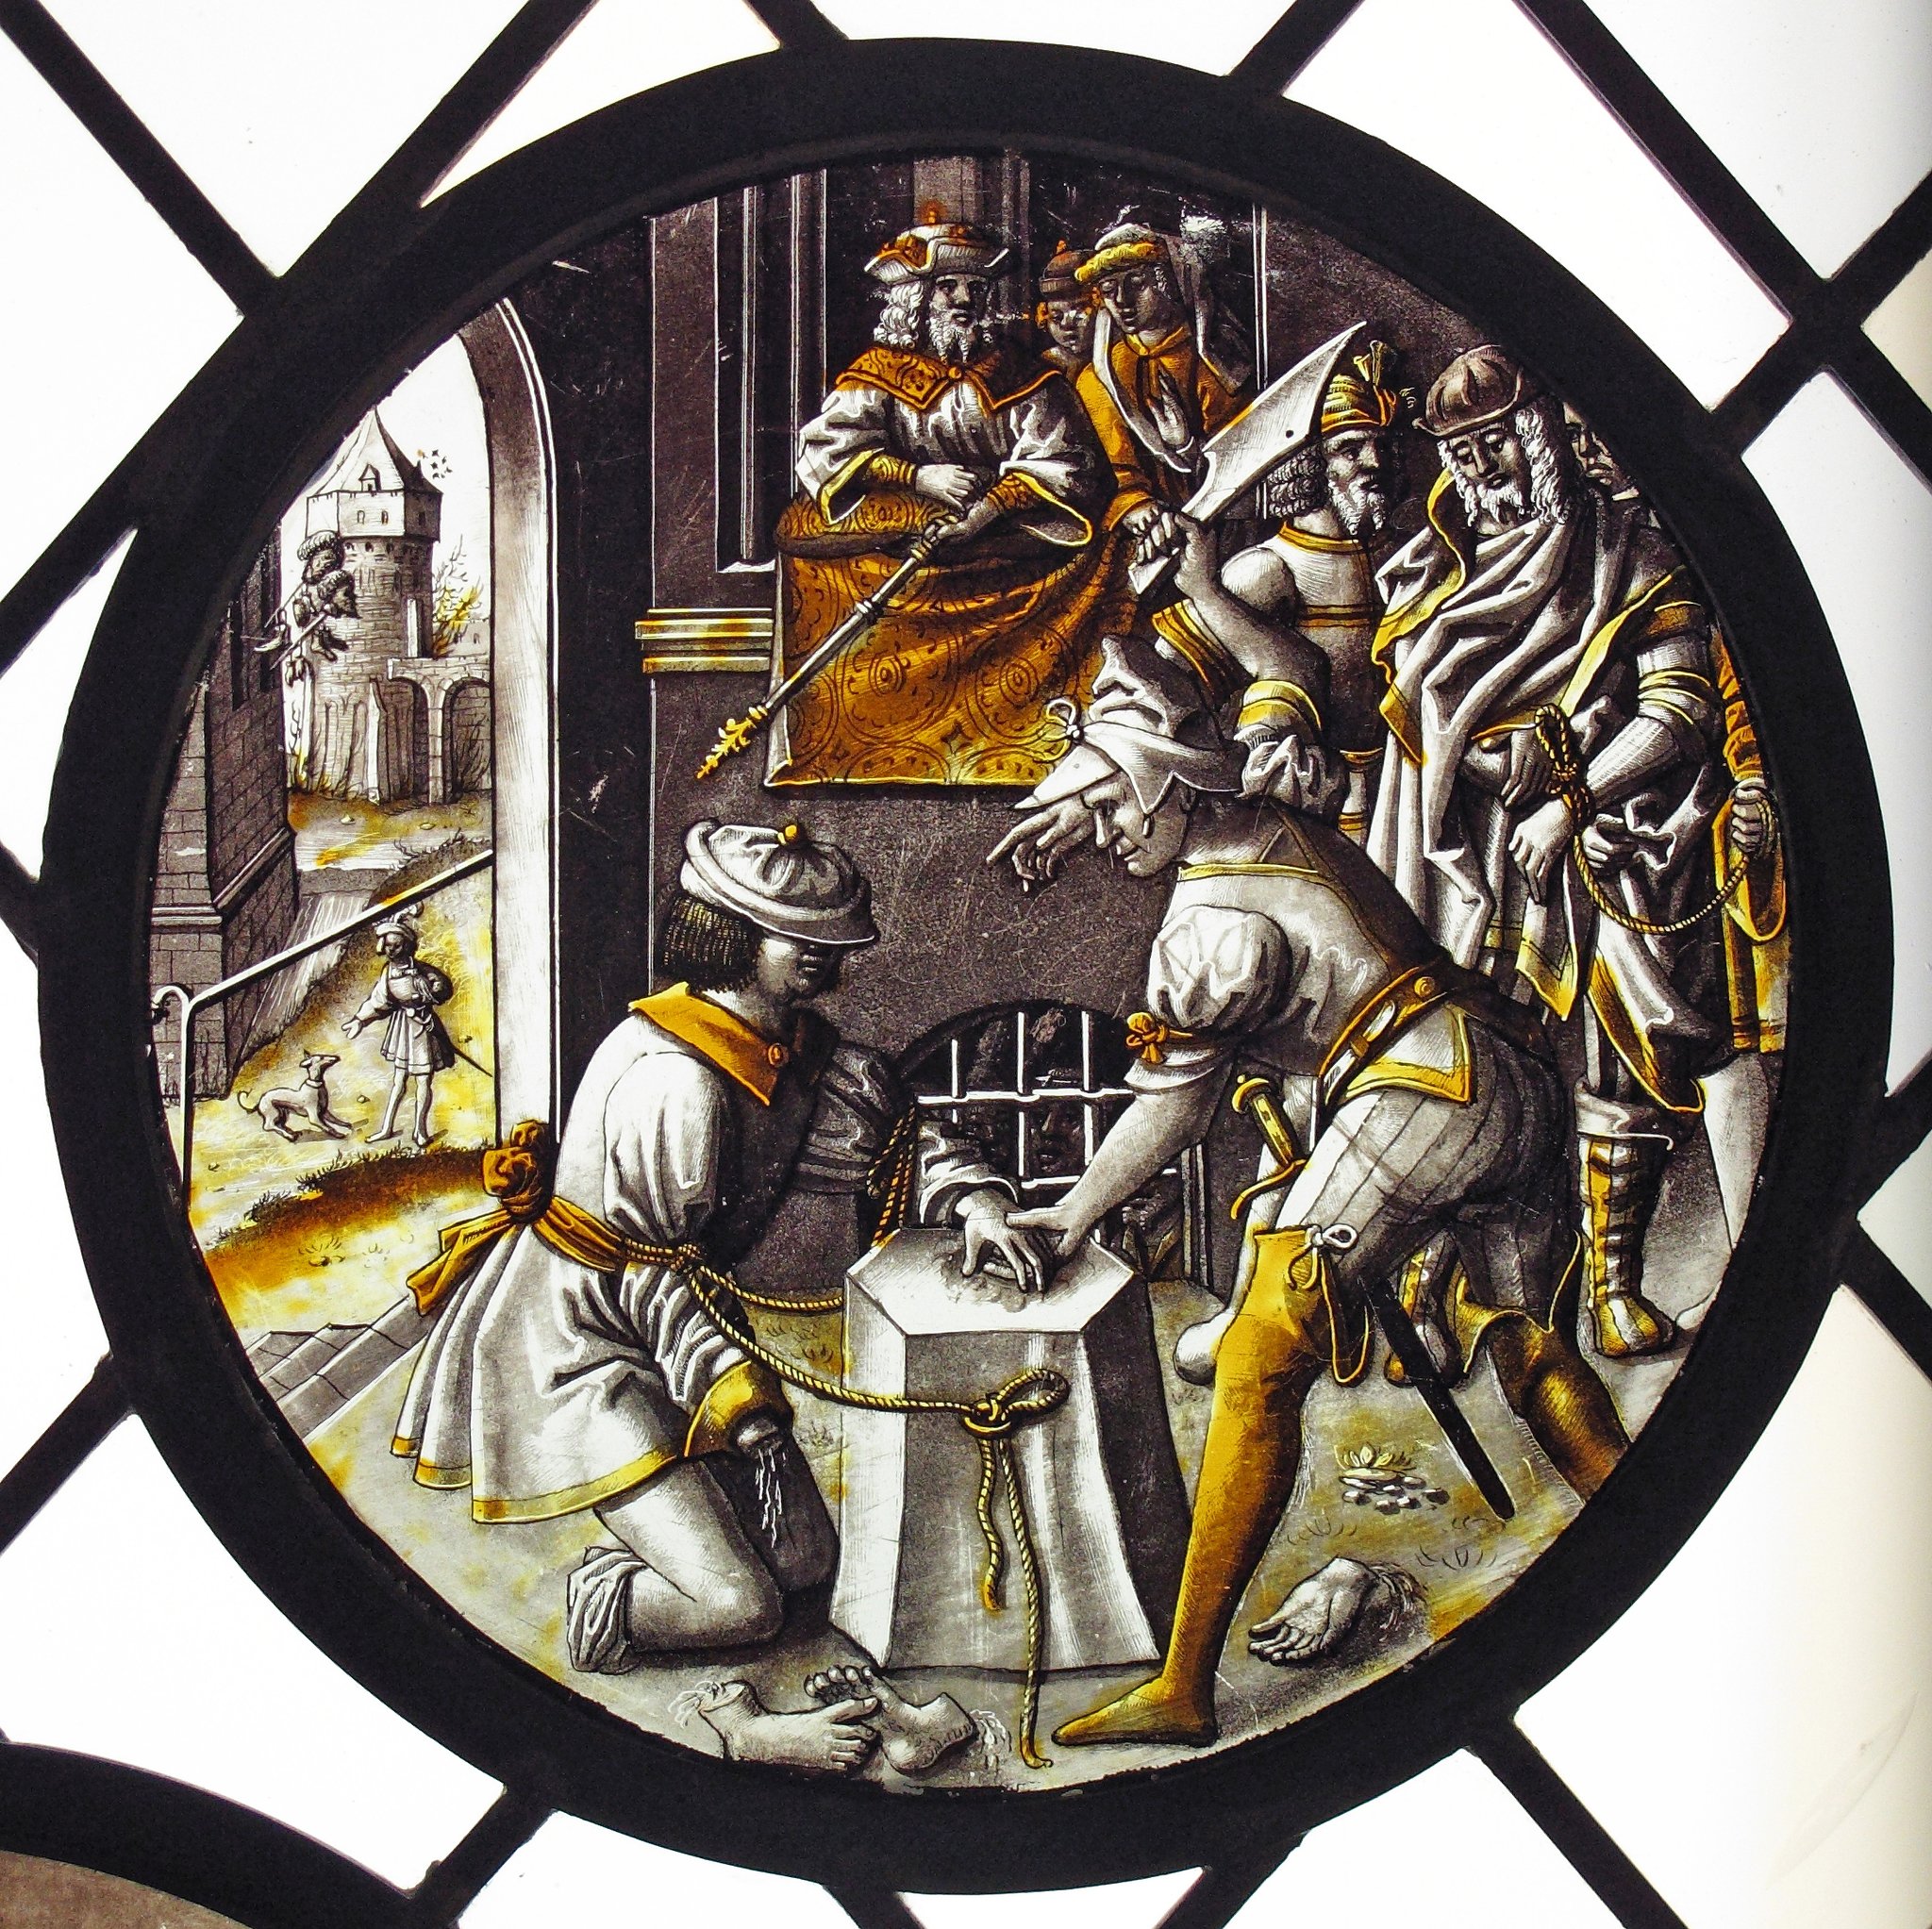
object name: roundel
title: Roundel with Martyrdom of Saint Jacobus Intercisus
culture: north netherlandish or south netherlandish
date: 1520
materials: glass, paint, pigment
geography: netherlands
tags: suffering,men,saints